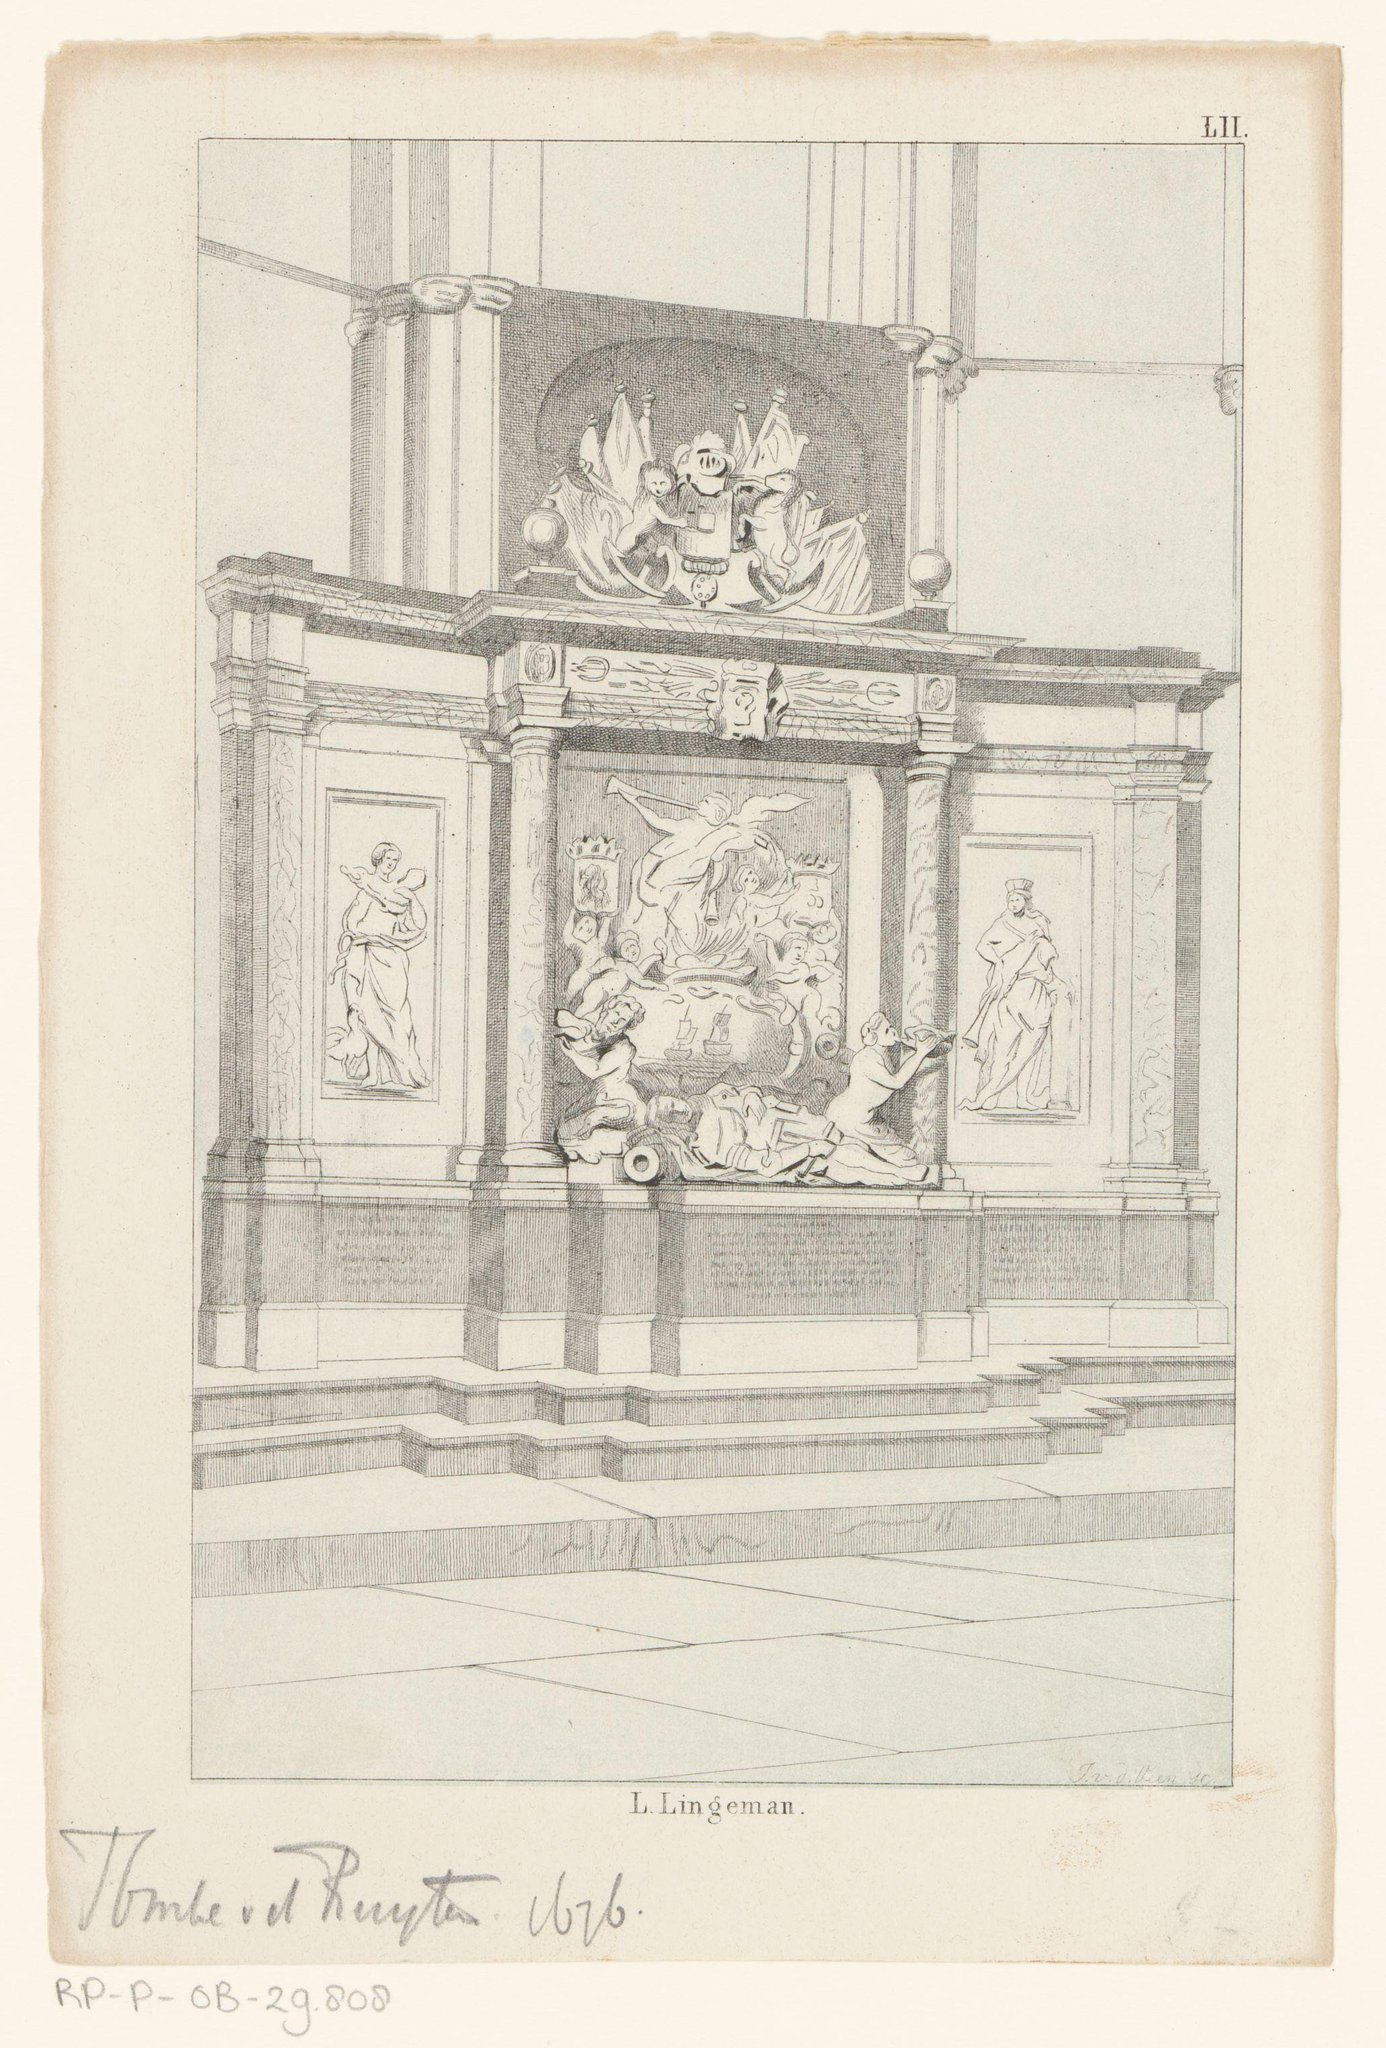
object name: print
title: Graf van Michiel Adriaenszoon de Ruyter in de Nieuwe Kerk te Amsterdam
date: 1841-1860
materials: paper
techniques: tone lithography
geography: netherlands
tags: flushing, michiel adriaenszoon de ruyter, grave, tomb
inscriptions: collector's mark: Lugt 2228